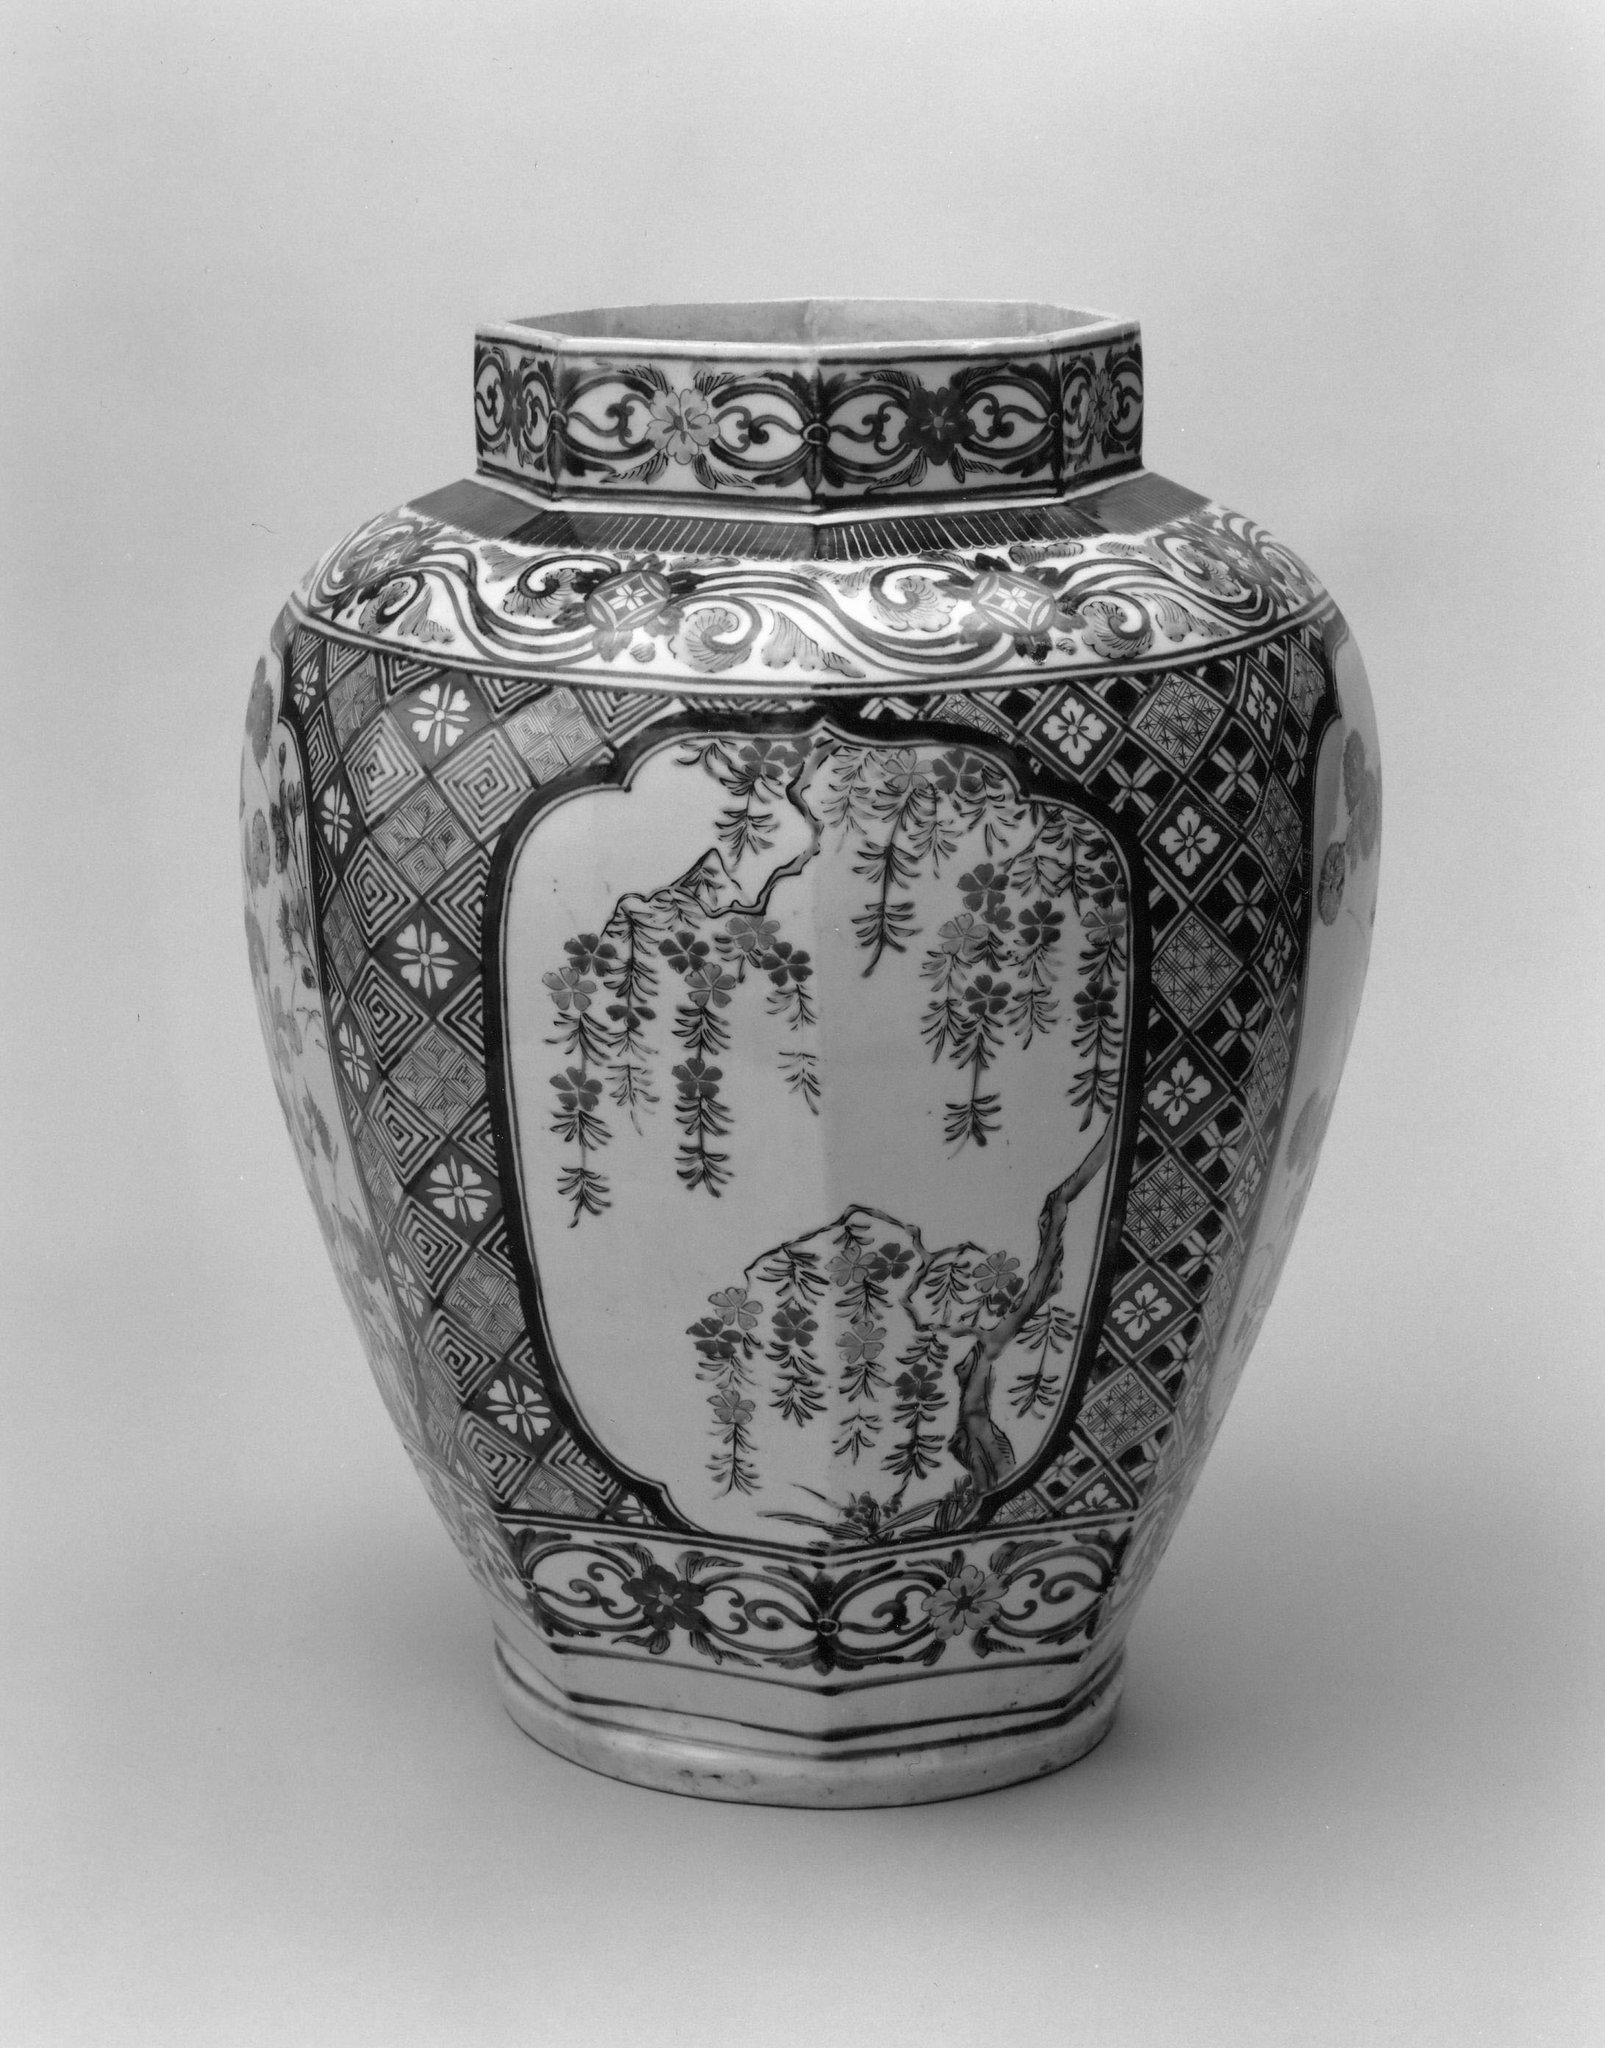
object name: jar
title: Octagonal Jar with Decoration of Flowering Cherry and Chrysanthemum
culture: japanese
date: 1667-1700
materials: enamel, porcelain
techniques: overglaze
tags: flowers,trees